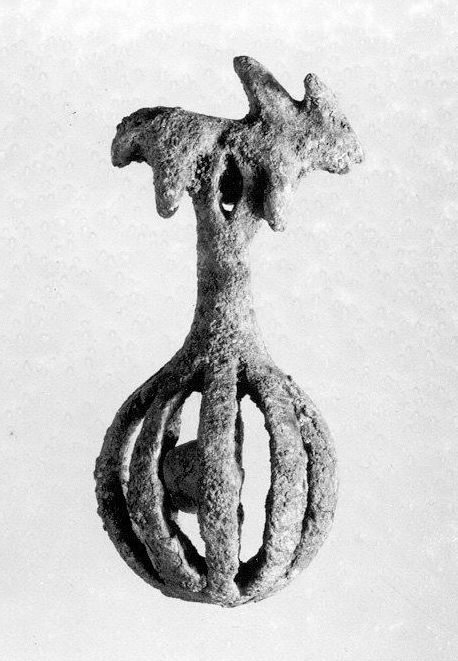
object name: rattle bell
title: Openwork rattle bell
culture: iranian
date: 1000-1 BCE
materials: bronze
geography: iran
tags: animals